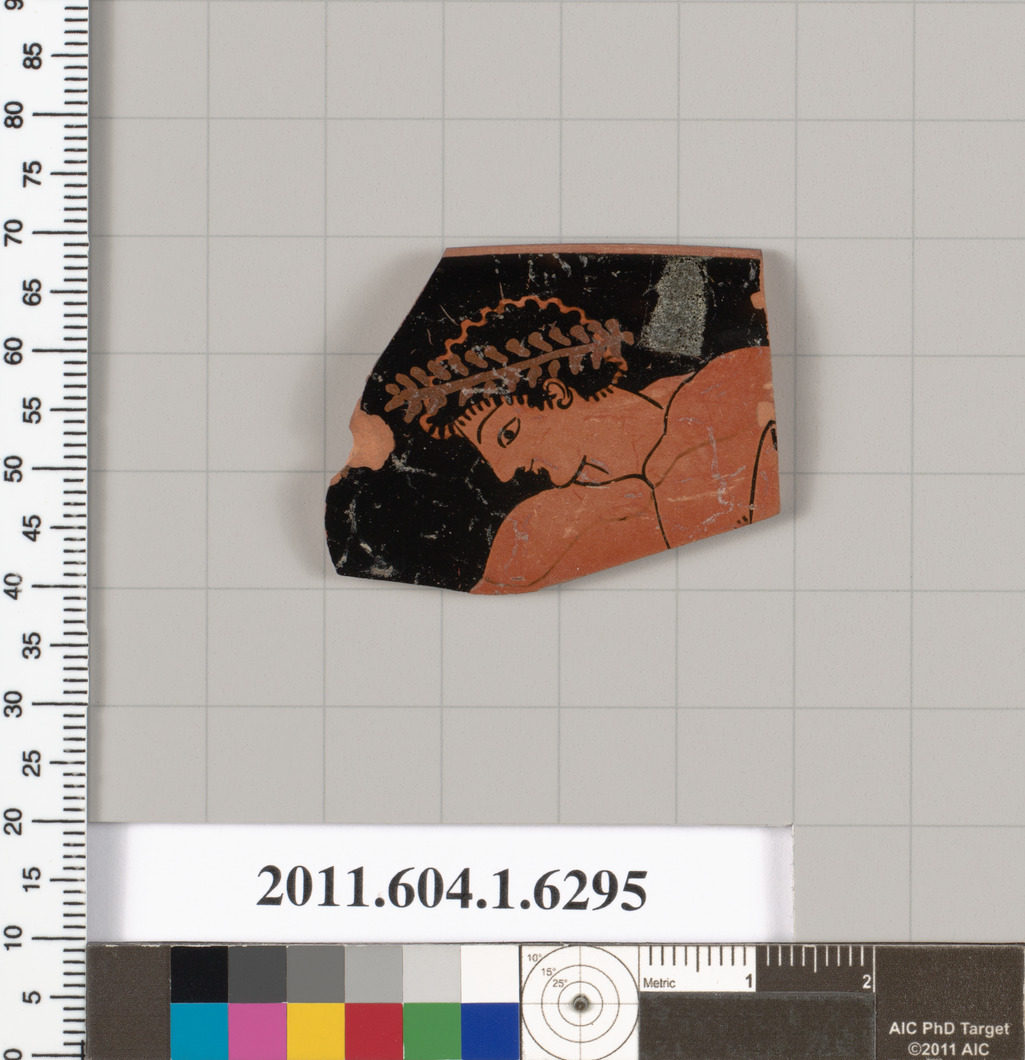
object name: kylix fragment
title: Terracotta rim fragment of a kylix (drinking cup)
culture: greek, attic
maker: onesimos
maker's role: artist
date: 500-480 BCE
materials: terracotta